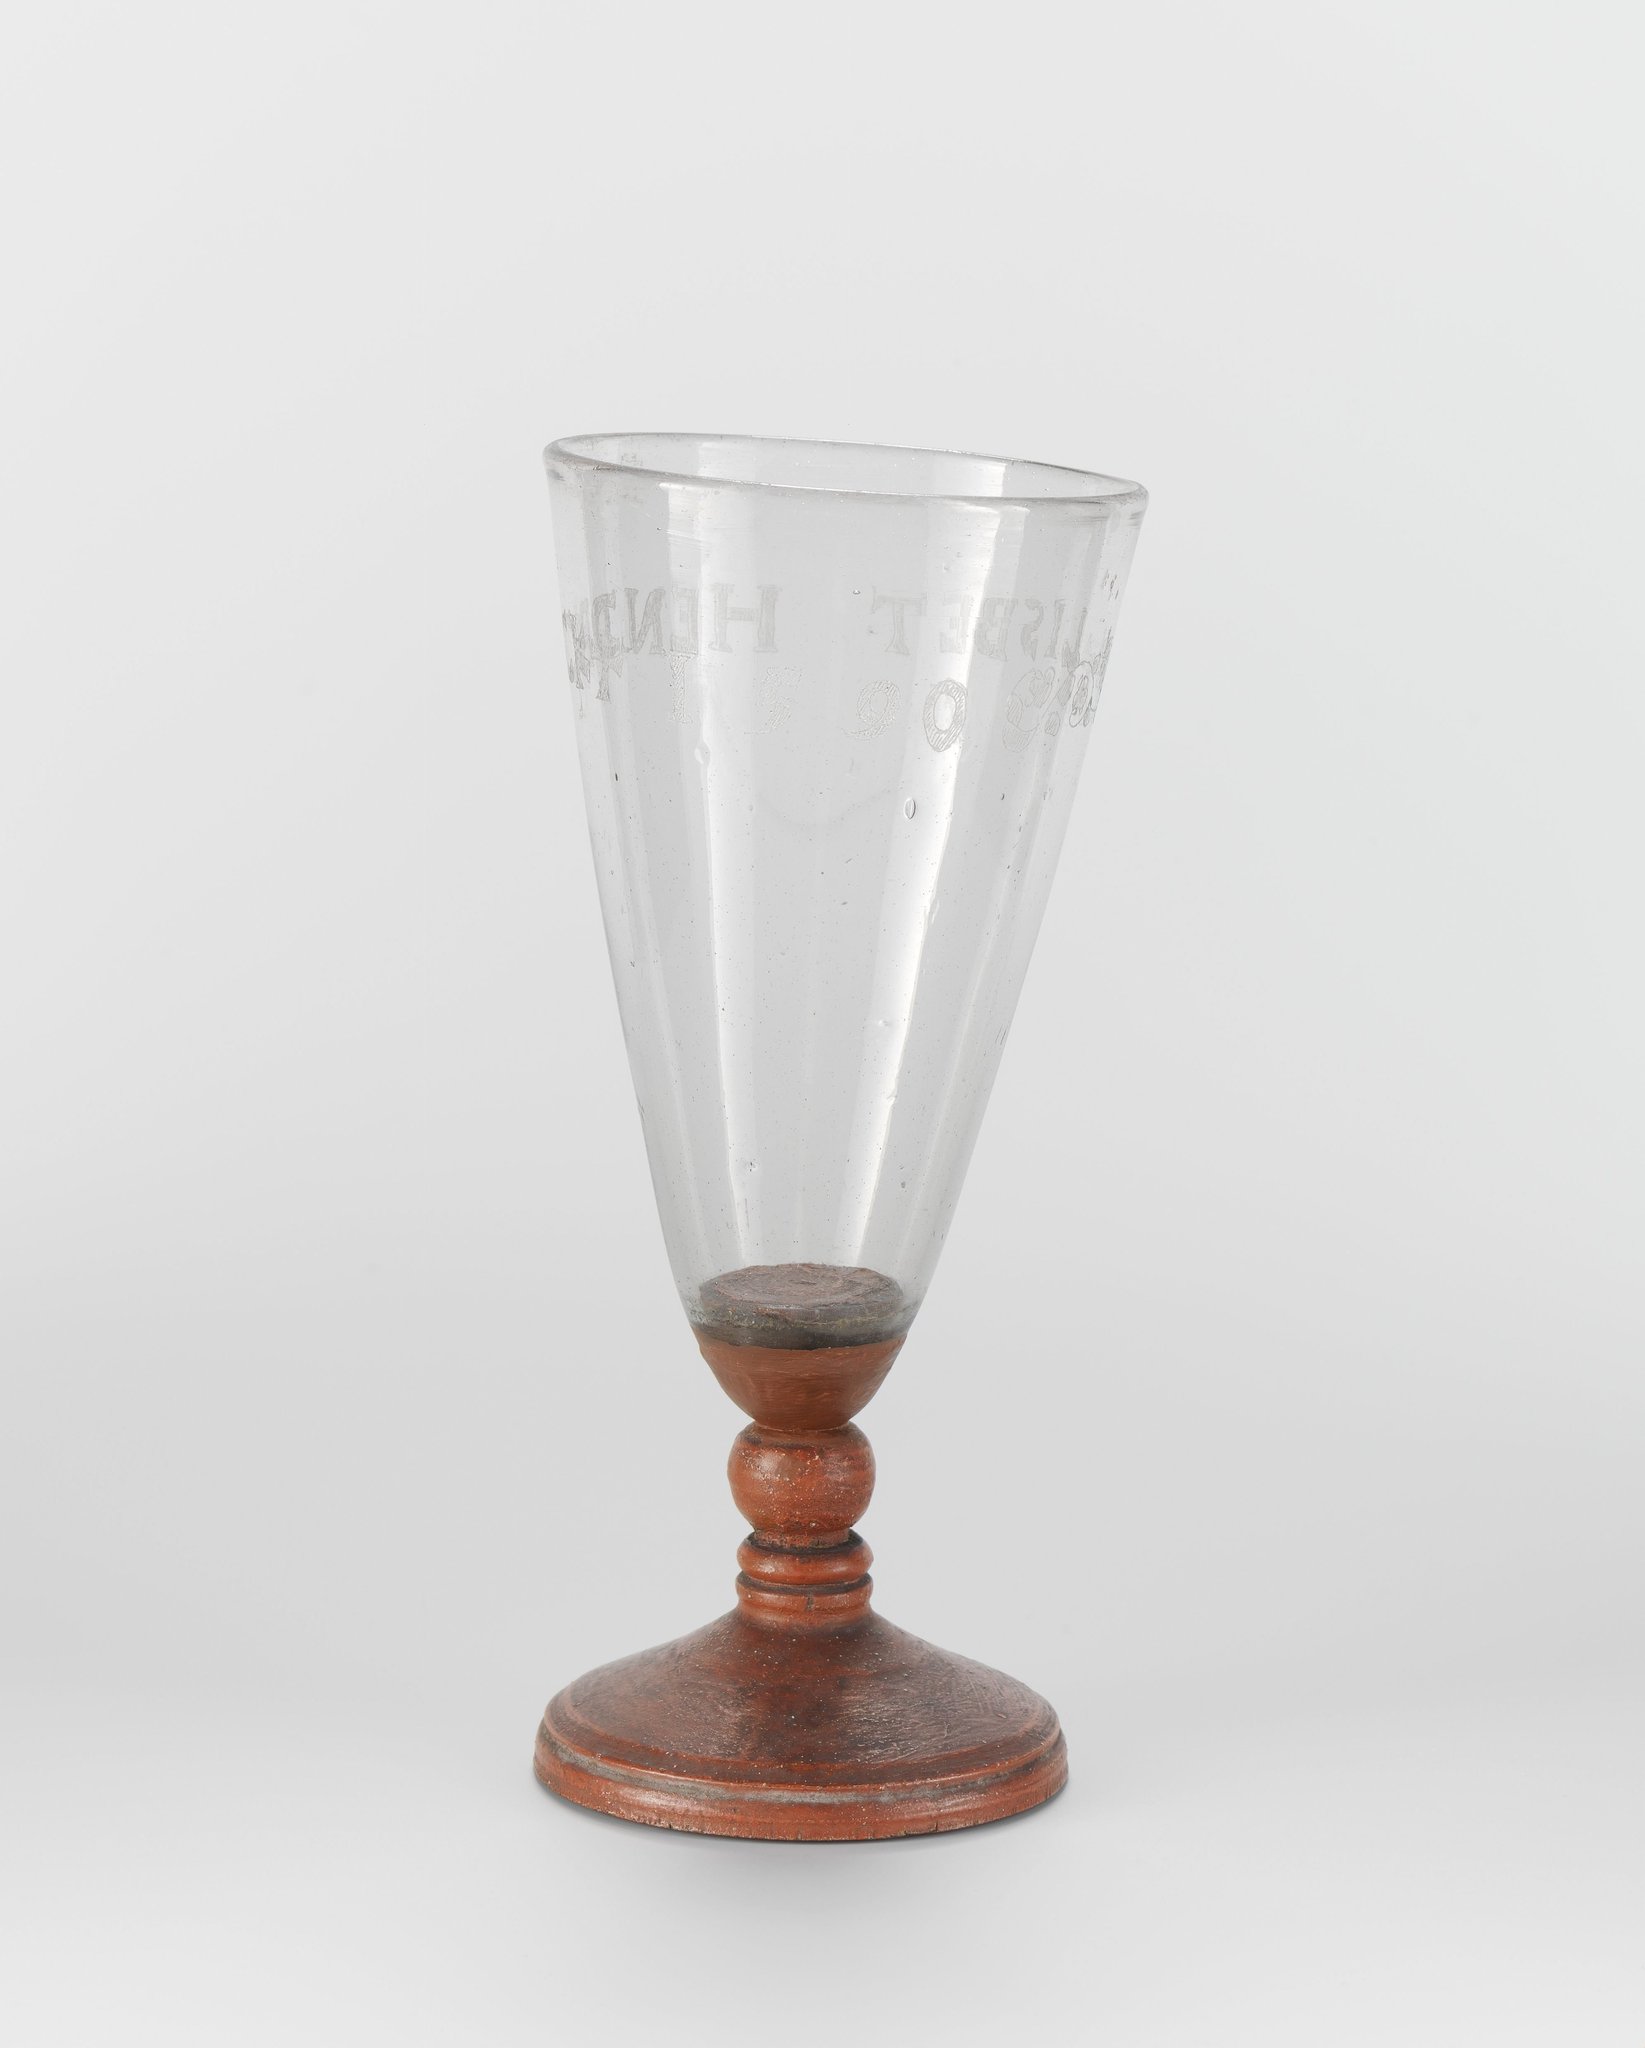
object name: goblet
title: Kelkglas met de gegraveerde tekst: LISBET HENDRICKS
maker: Anonymous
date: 1590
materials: glass, wood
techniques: diamond point engraving, façon de venise, gilding, glassblowing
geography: northern netherlands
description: Conische, geprofileerde voet van rood geschilderd hout. De stam opgebouwd uit een platte en een ronde, rood geschilderde, houten nodus. Trechtervormige kelk. Langs de rand resten van verguldsel. Op de kelk is de naam LISBET HENDRICKS, een bladrank en het jaartal 1590 gegraveerd.